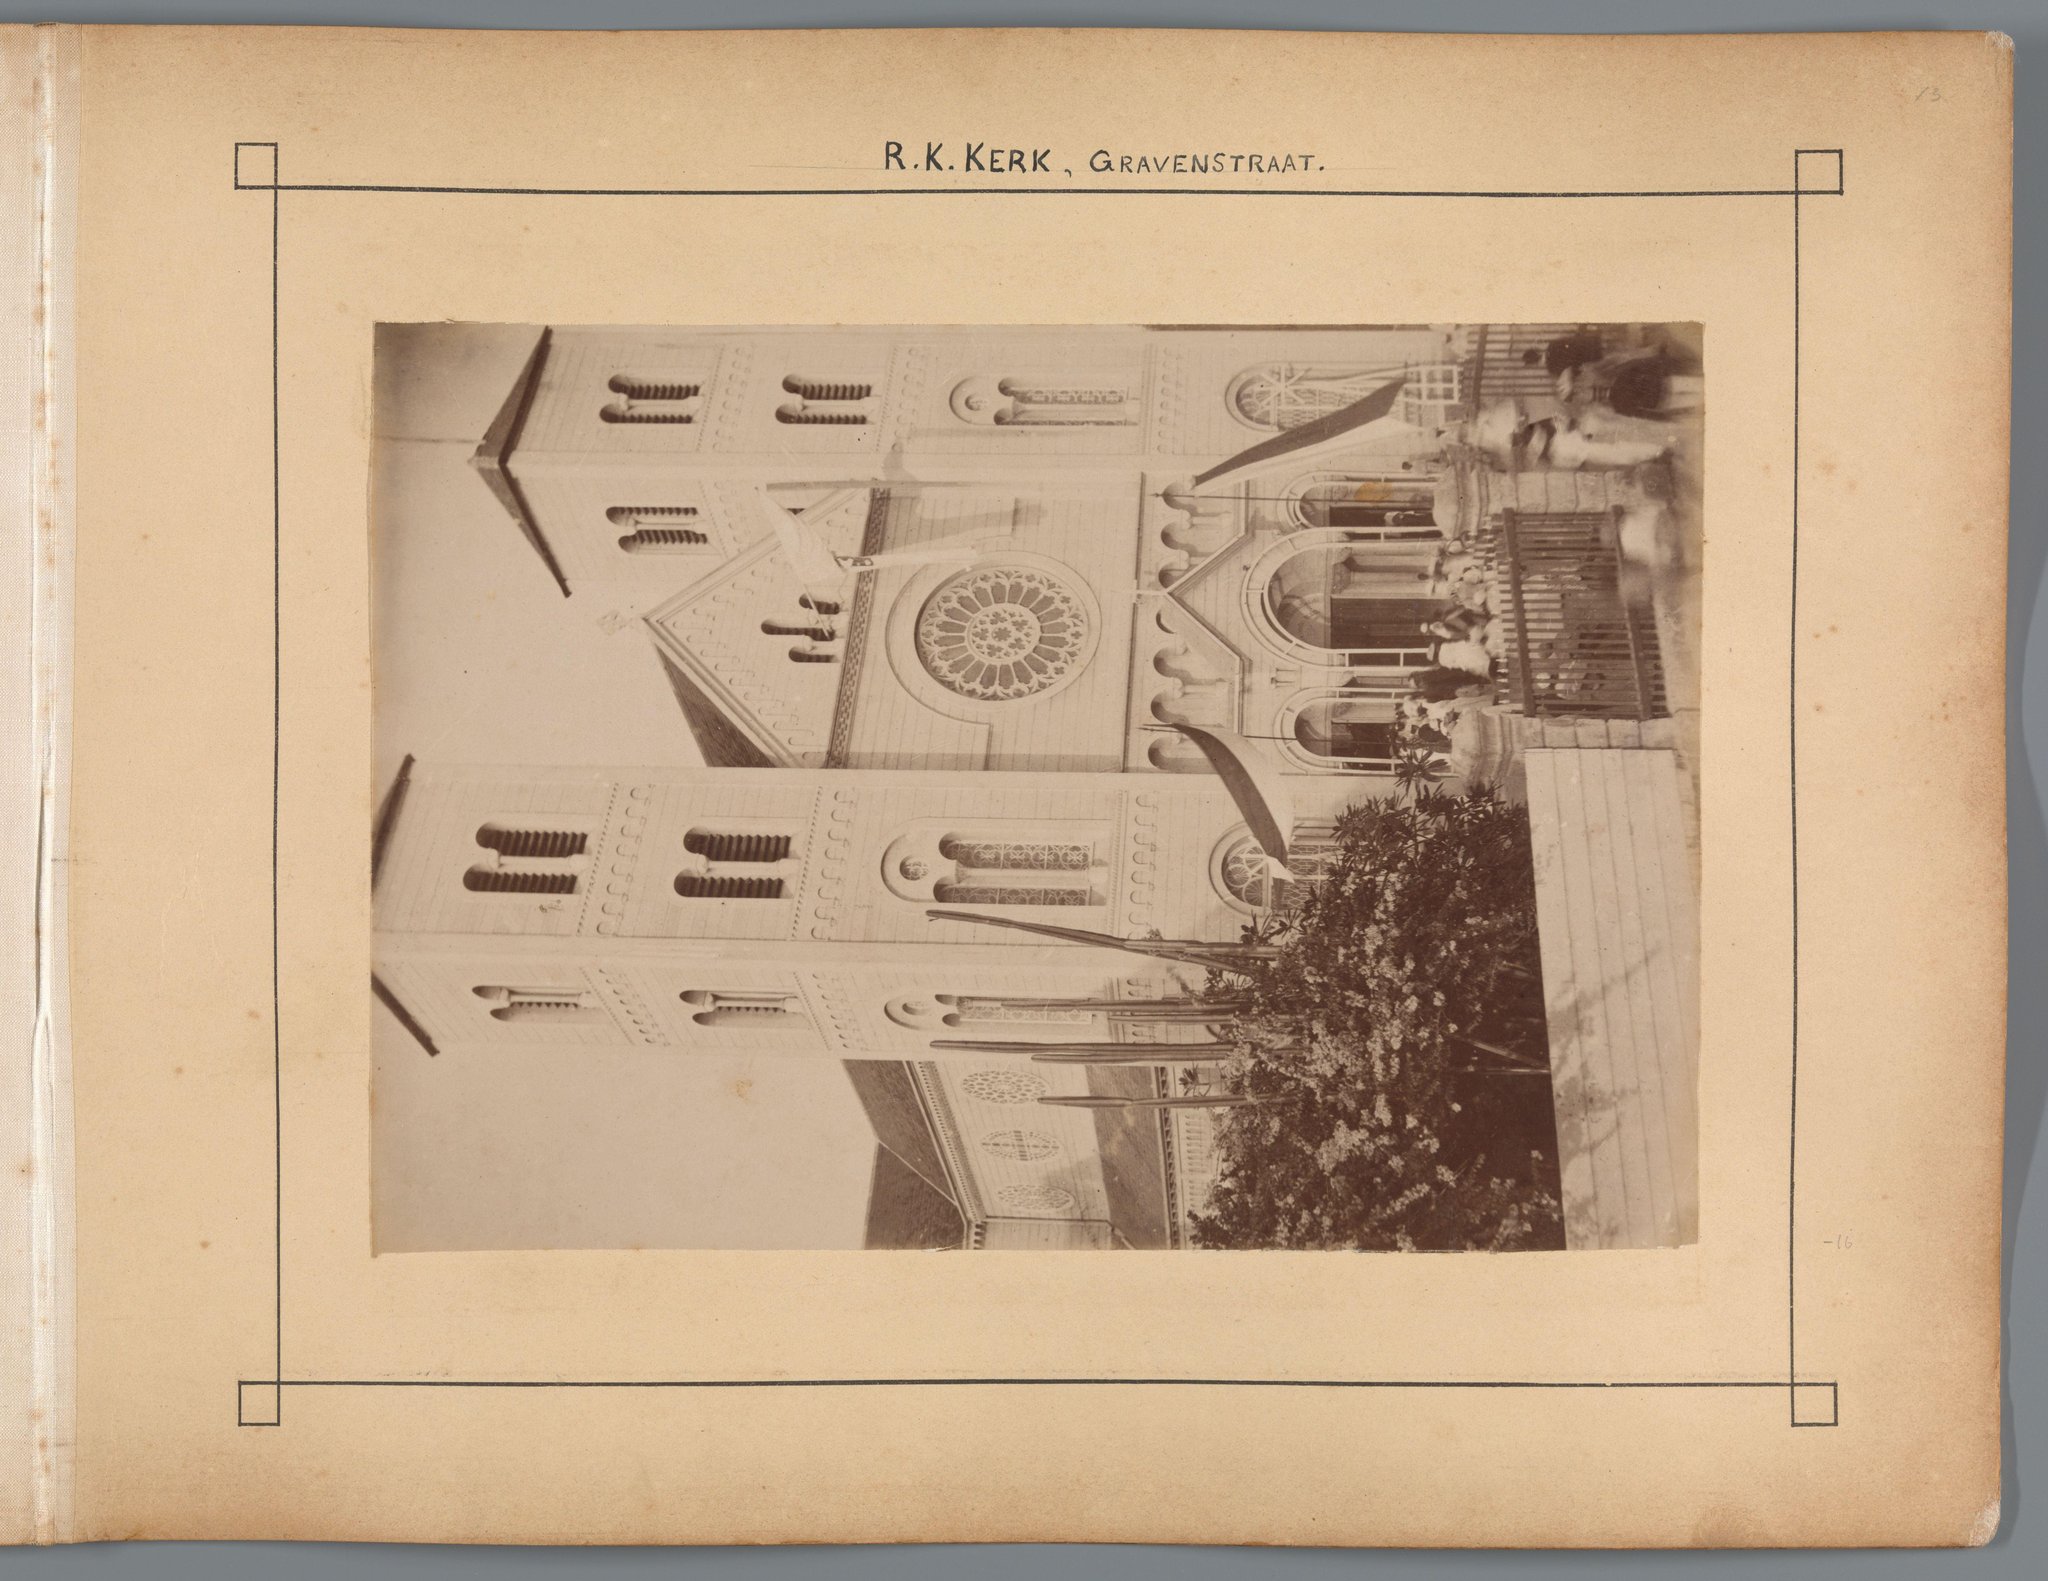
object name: photograph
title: R.K. Kerk, Gravenstraat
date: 1898-1902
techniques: albumen print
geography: suriname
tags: suriname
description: Sint-Petrus-en-Pauluskathedraal aan de Gravenstraat te Paramaribo.